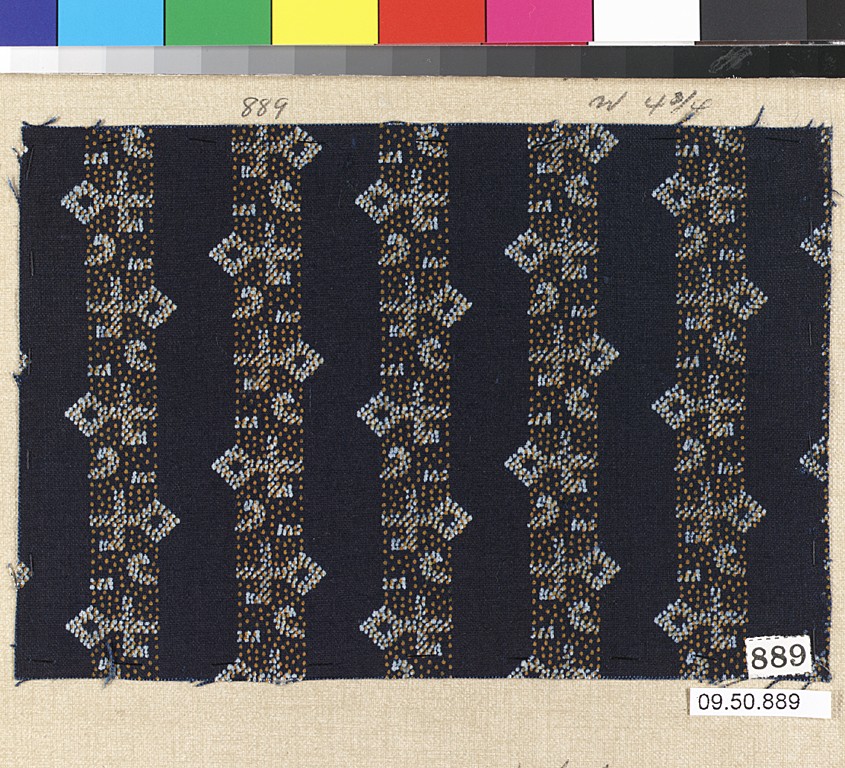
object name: piece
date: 1801-1900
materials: cotton